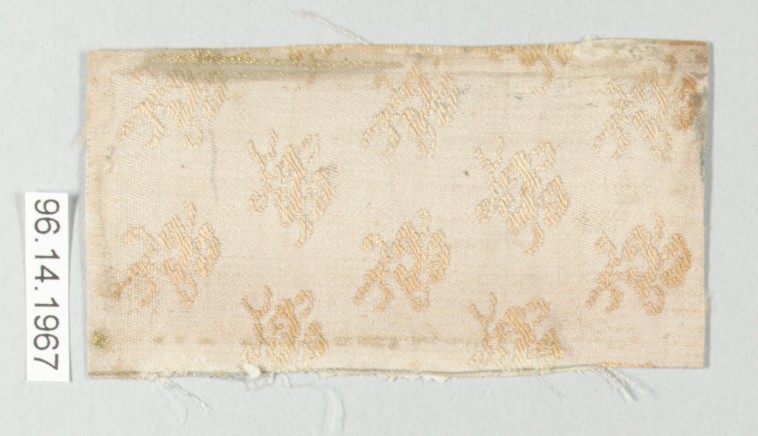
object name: piece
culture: japanese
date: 1701-1900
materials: silk